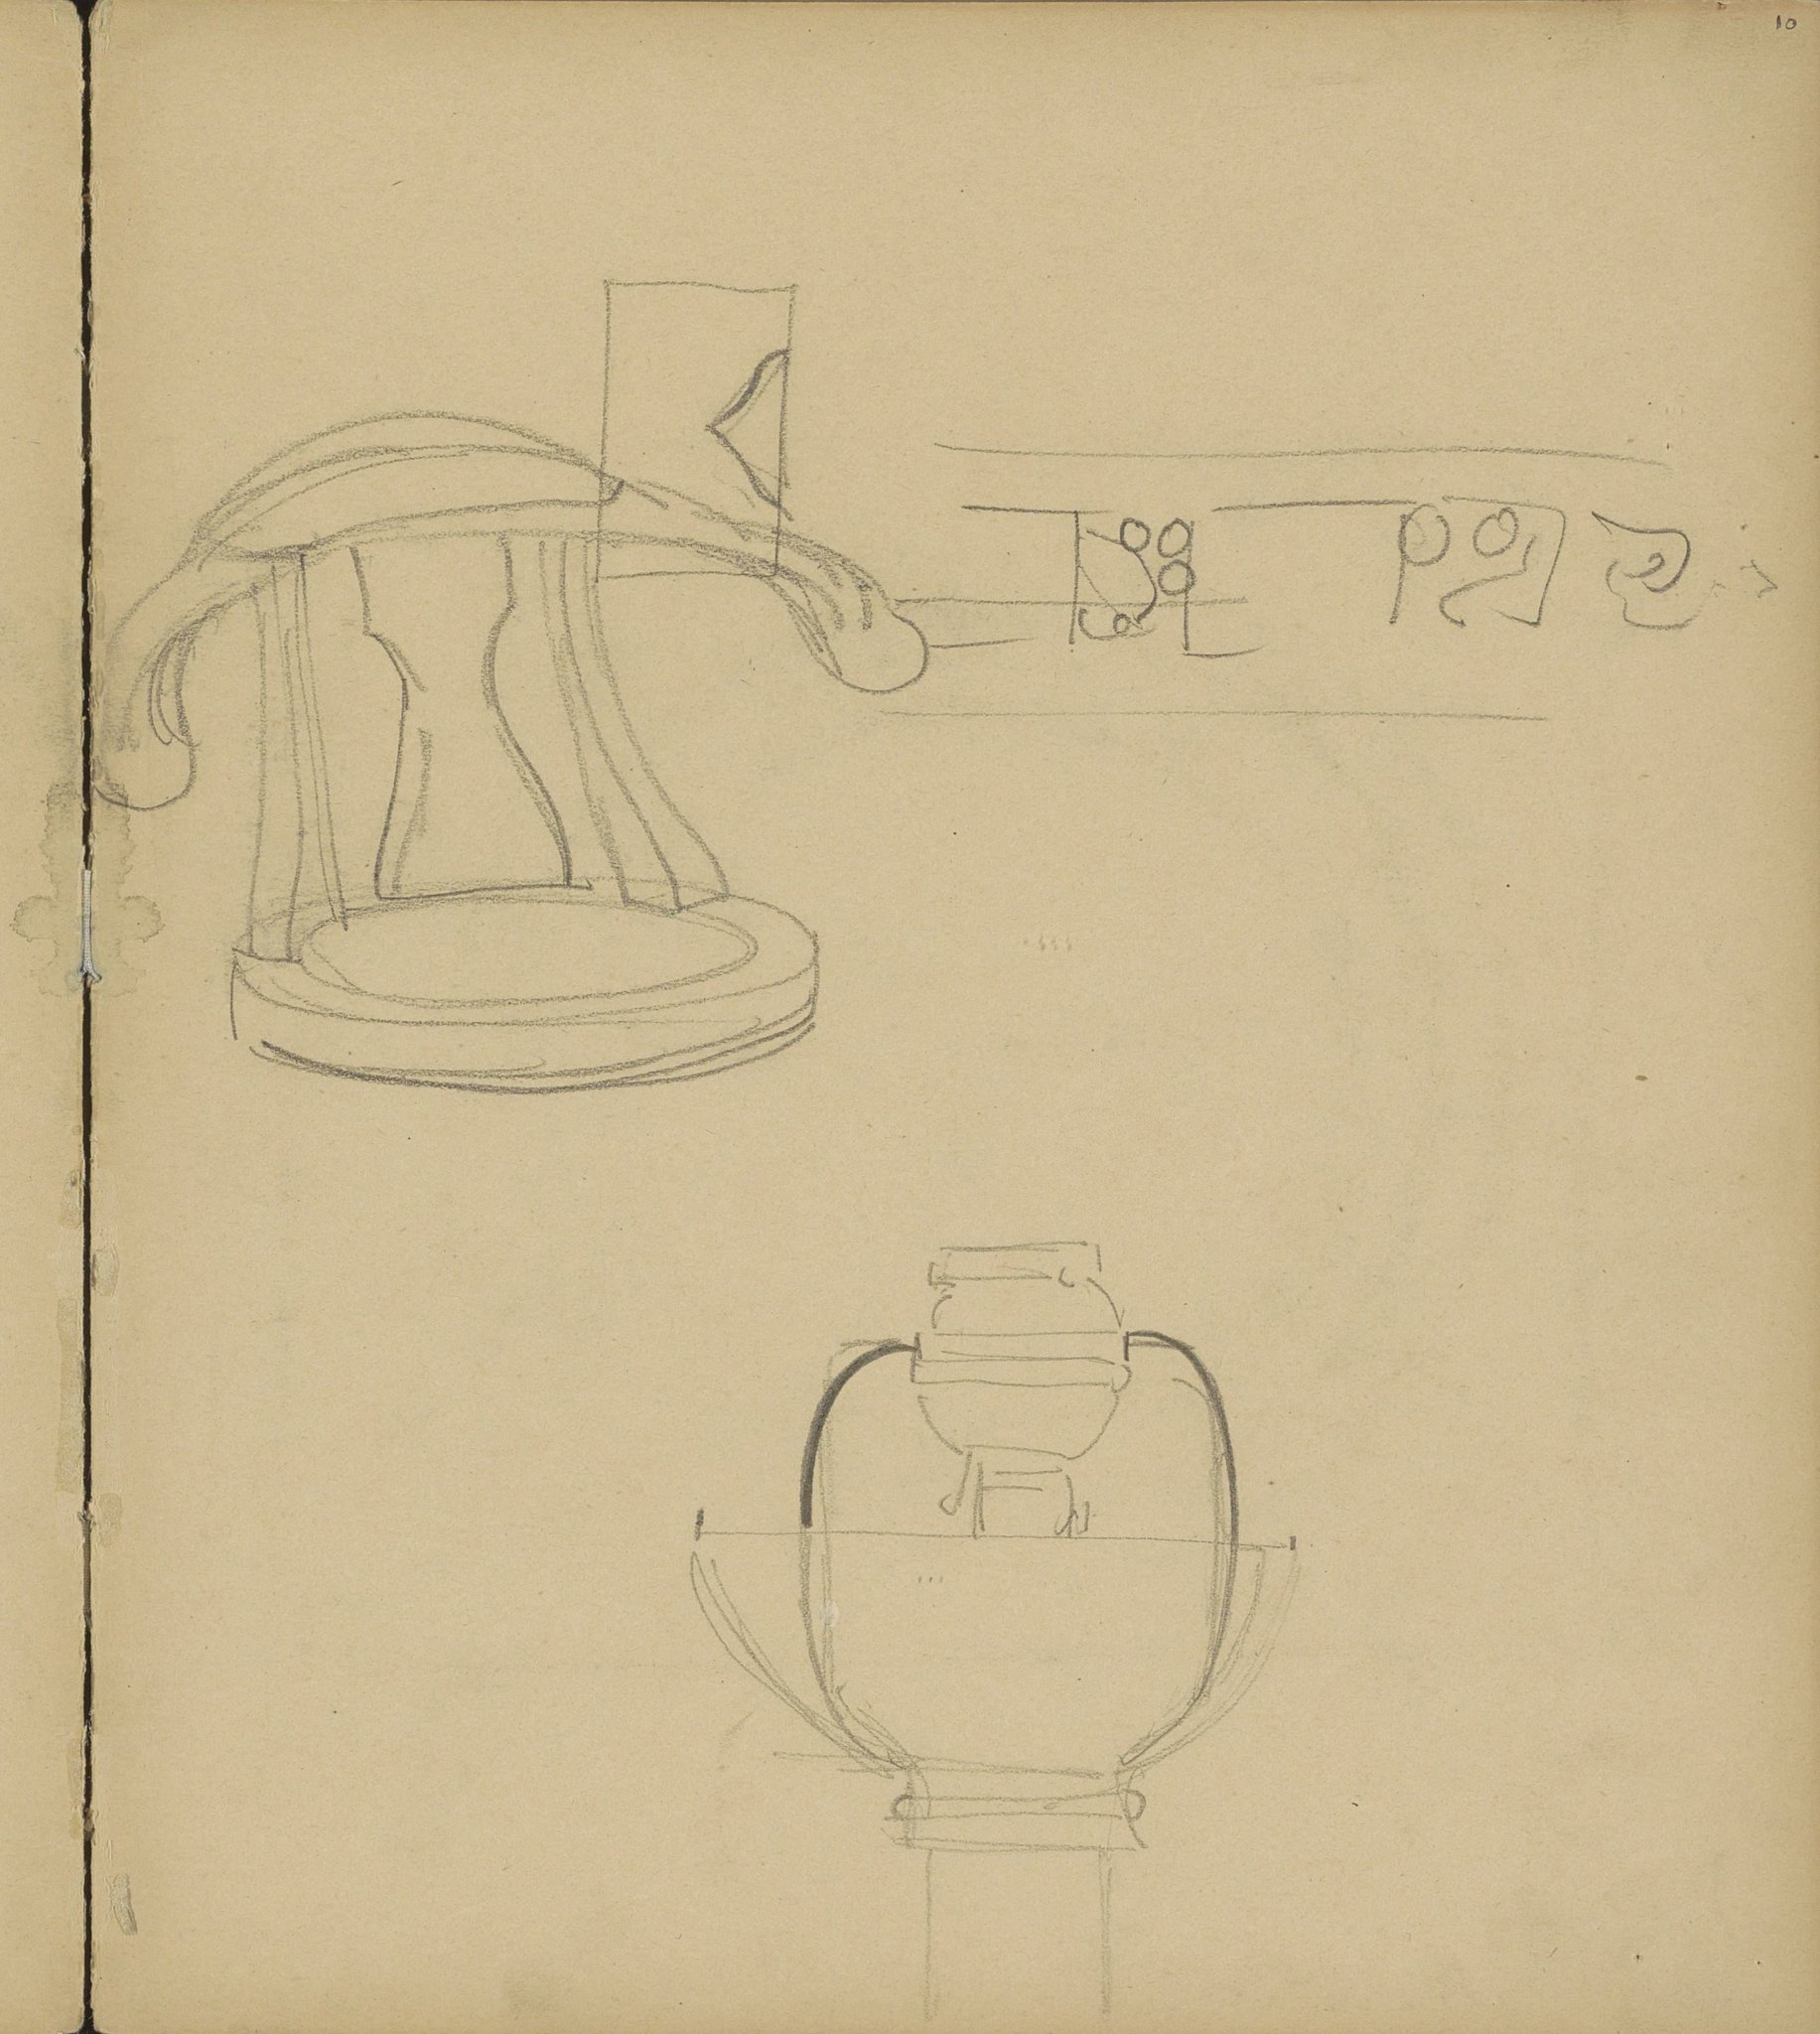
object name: sketchbook leaf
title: Ontwerp voor een stoelzitting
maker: carel adolph lion cachet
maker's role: draughtsman, print maker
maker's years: 1864-1945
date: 1906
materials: paper, pencil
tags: chair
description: Tevens een studie van een object, mogelijk een lamp. Blad 10 recto uit een schetsboek met 27 bladen.